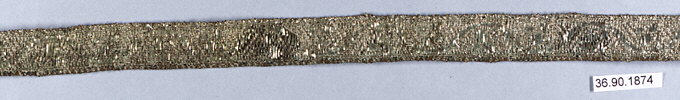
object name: galloon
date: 1801-1900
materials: metal thread